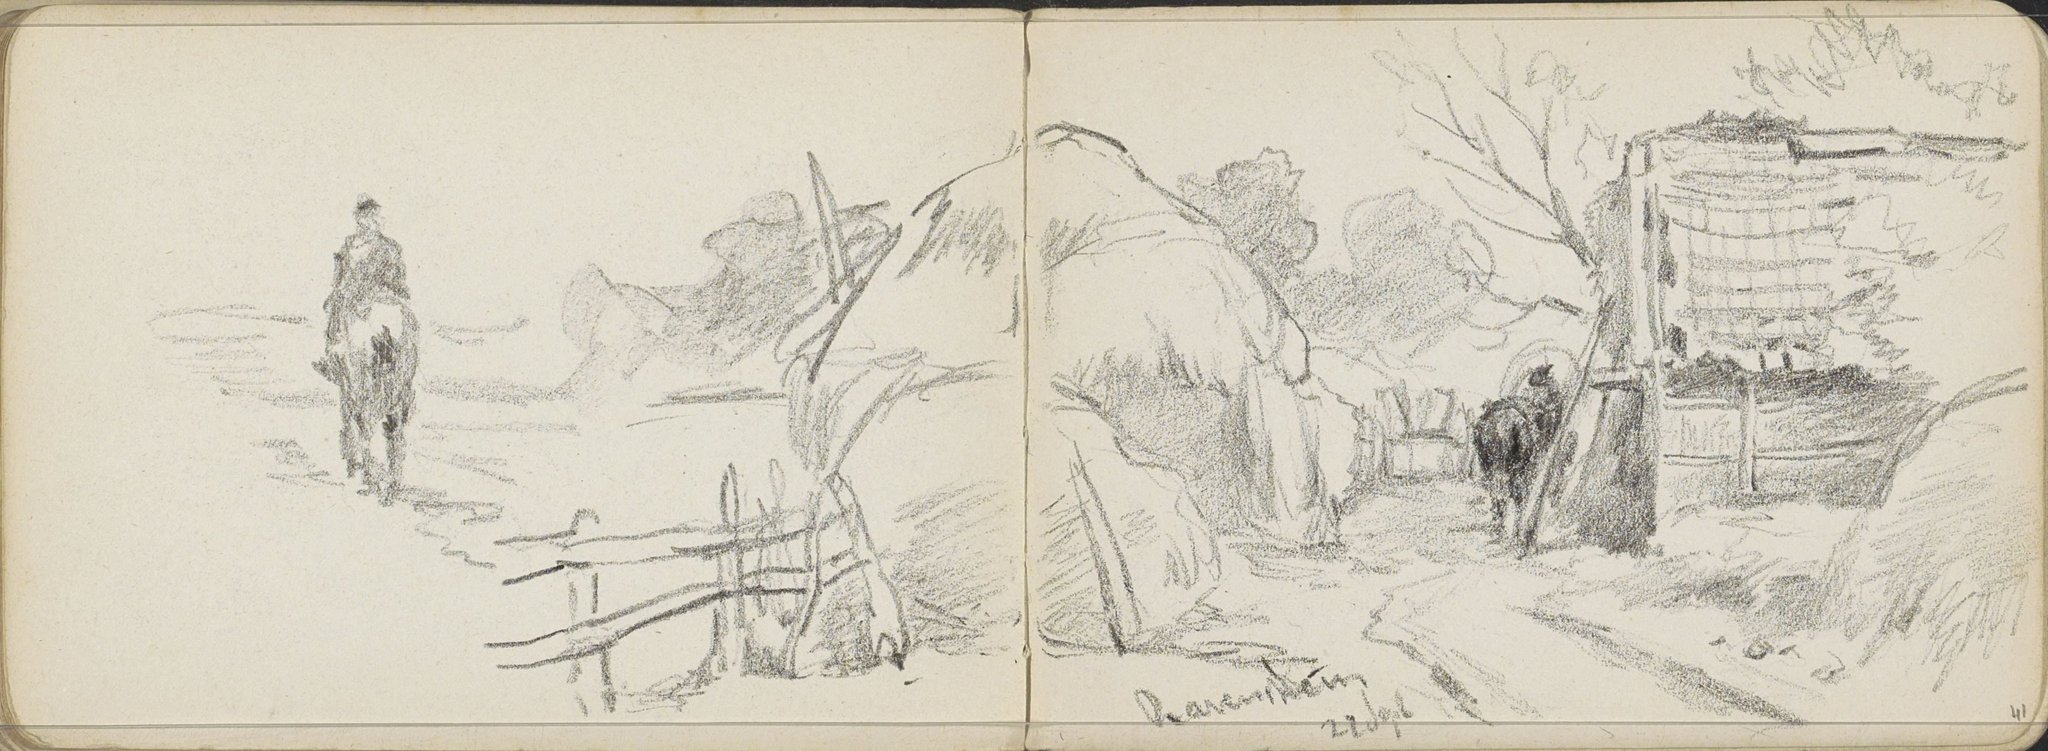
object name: sketchbook leaf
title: Hooiberg bij een schuur en een ruiter op een pad te Ravenstein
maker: willem cornelis rip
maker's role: draughtsman, painter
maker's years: 1856-1922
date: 1905-1909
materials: chalk, paper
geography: ravenstein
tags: riding a horse, ass, or mule; rider, horseman, barn, road, path, hay-stack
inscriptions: date and inscription: ‘Ravenstein/ 22 Sept’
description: Blad 40 verso en 41 recto uit een schetsboek met 42 bladen.